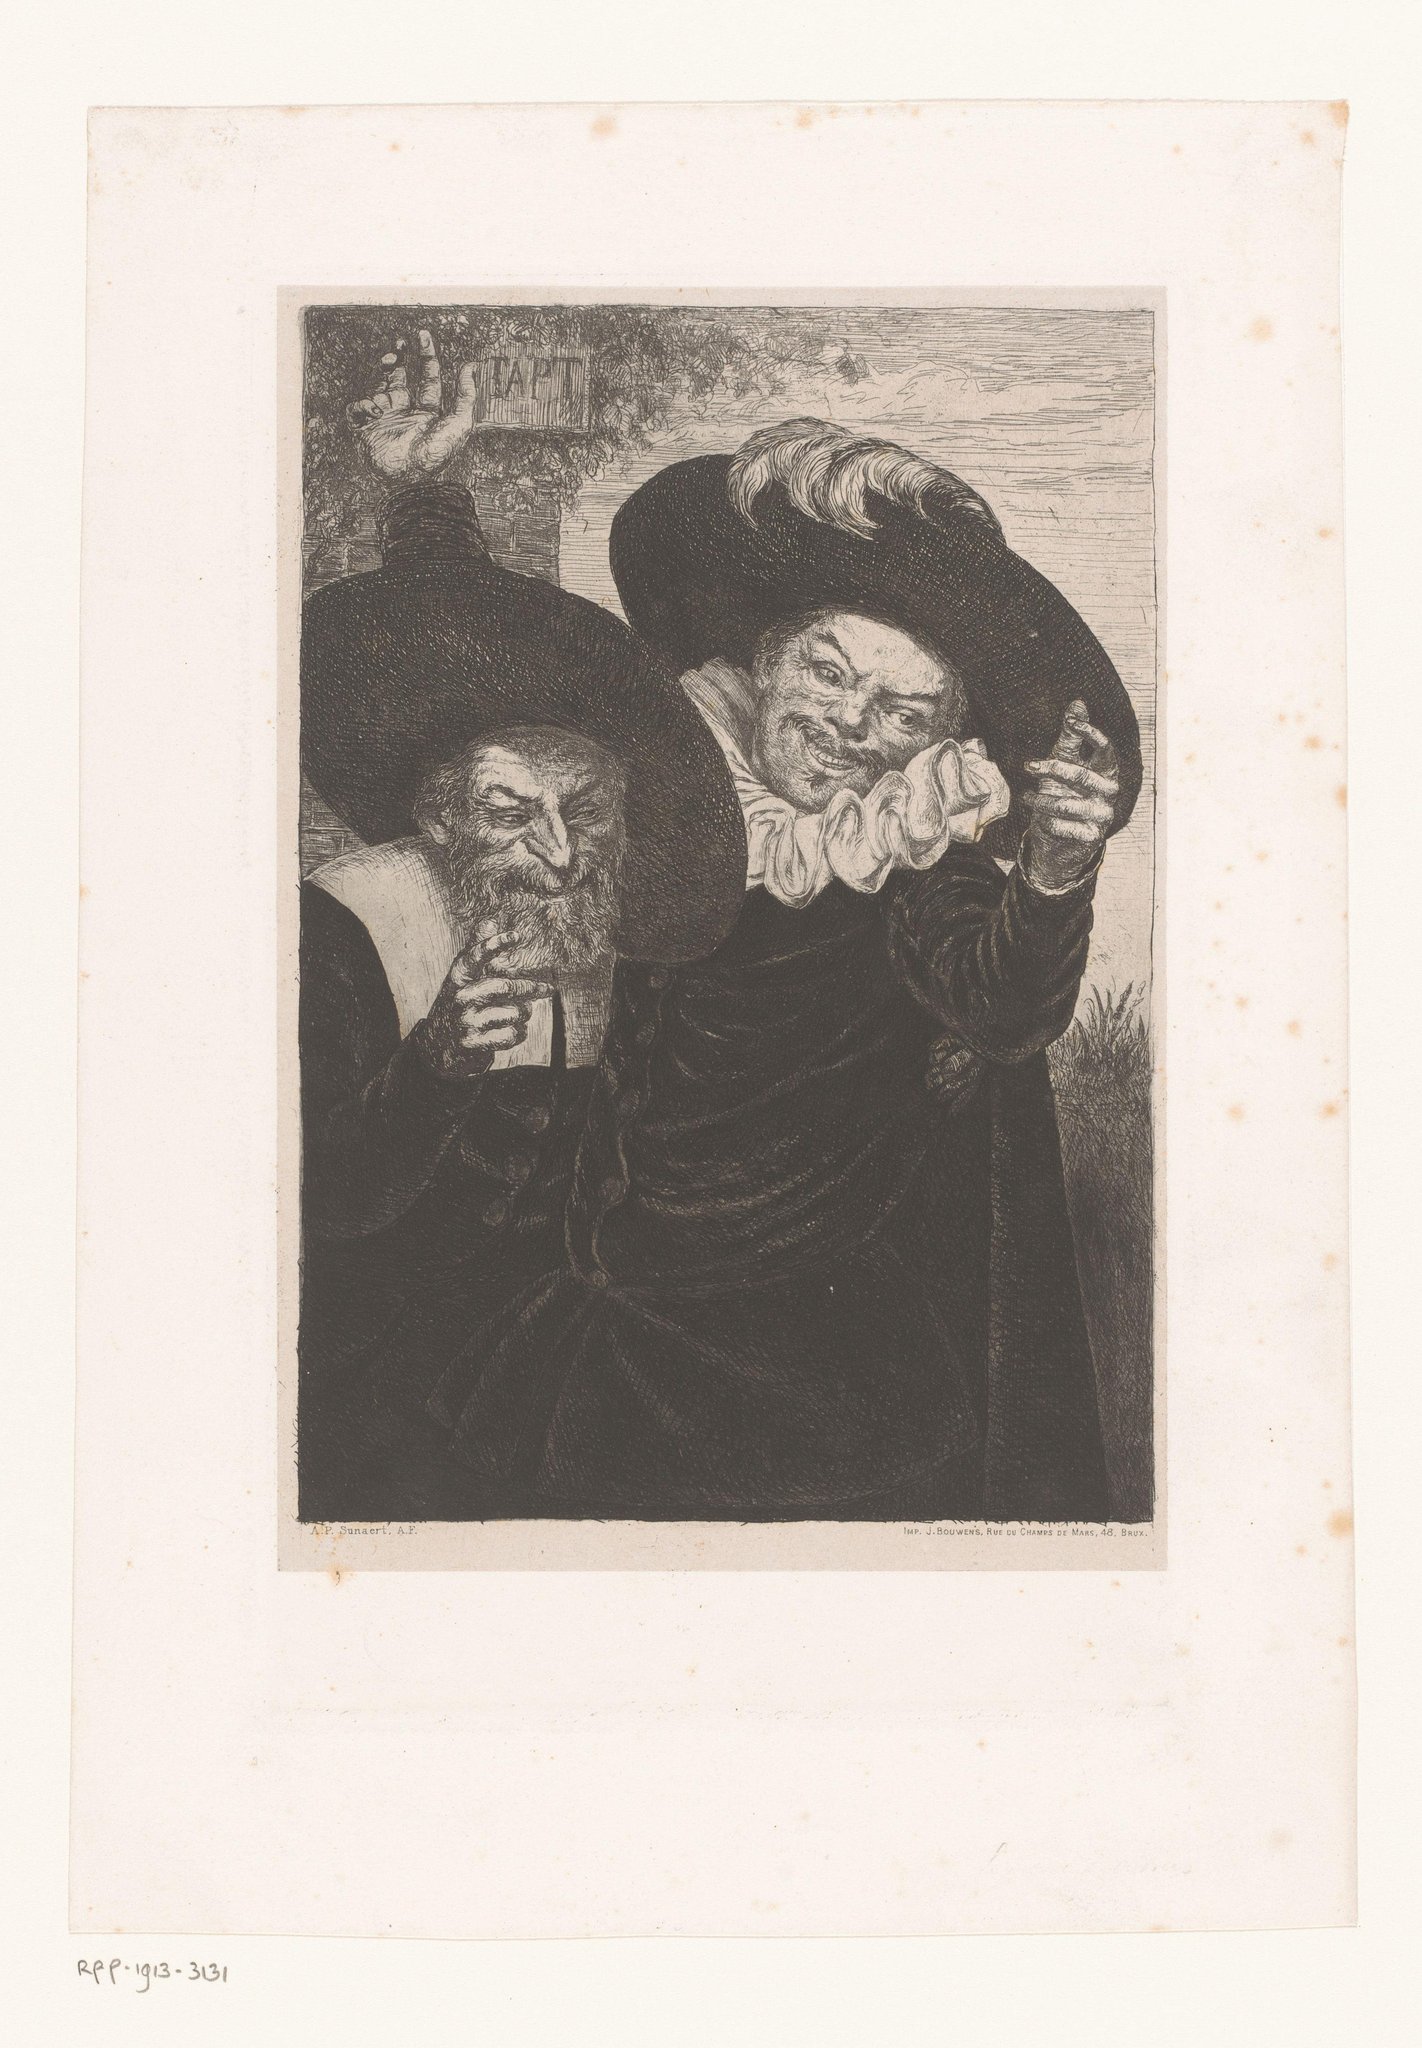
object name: print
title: Twee mannen met hoeden in zeventiende-eeuwse Nederlandse kledij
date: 1875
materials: paper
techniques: etching, intaglio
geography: brussels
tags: head-gear, adult man, historical costume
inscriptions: collector's mark: Lugt 2228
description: In de inventaris getiteld: De bons vivants. De prent deed in 1875 mee in een wedstrijd in Brussel georganiseerd door het tijdschrift 'Journal des Beaux-Arts et de la Littérature'. Prent verschenen in: Album du journal des beaux-arts, dix eaux-fortes inédites. Brussel, Parijs en Leipzig: s.n., 1875.